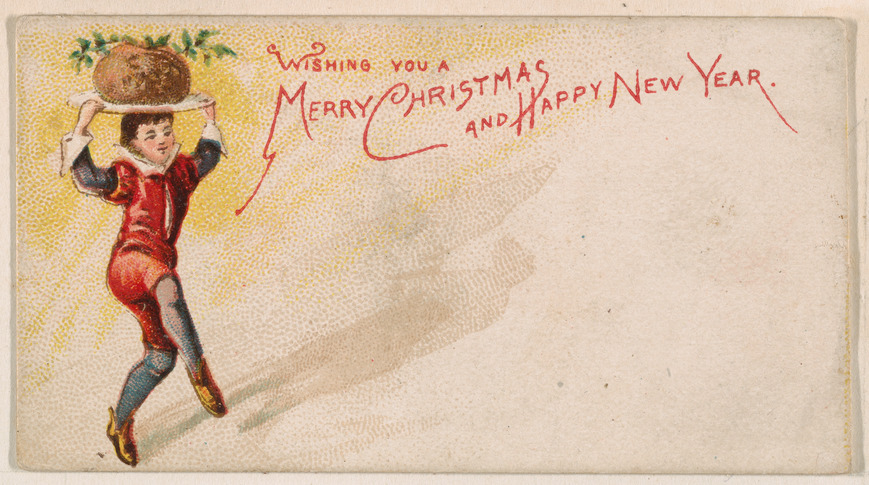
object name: print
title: Wishing You a Merry Christmas and Happy New Year, from the New Years 1890 series (N227) issued by Kinney Bros.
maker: kinney brothers tobacco company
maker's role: publisher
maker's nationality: american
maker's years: 1869-2011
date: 1889-1890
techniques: color lithograph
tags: boys